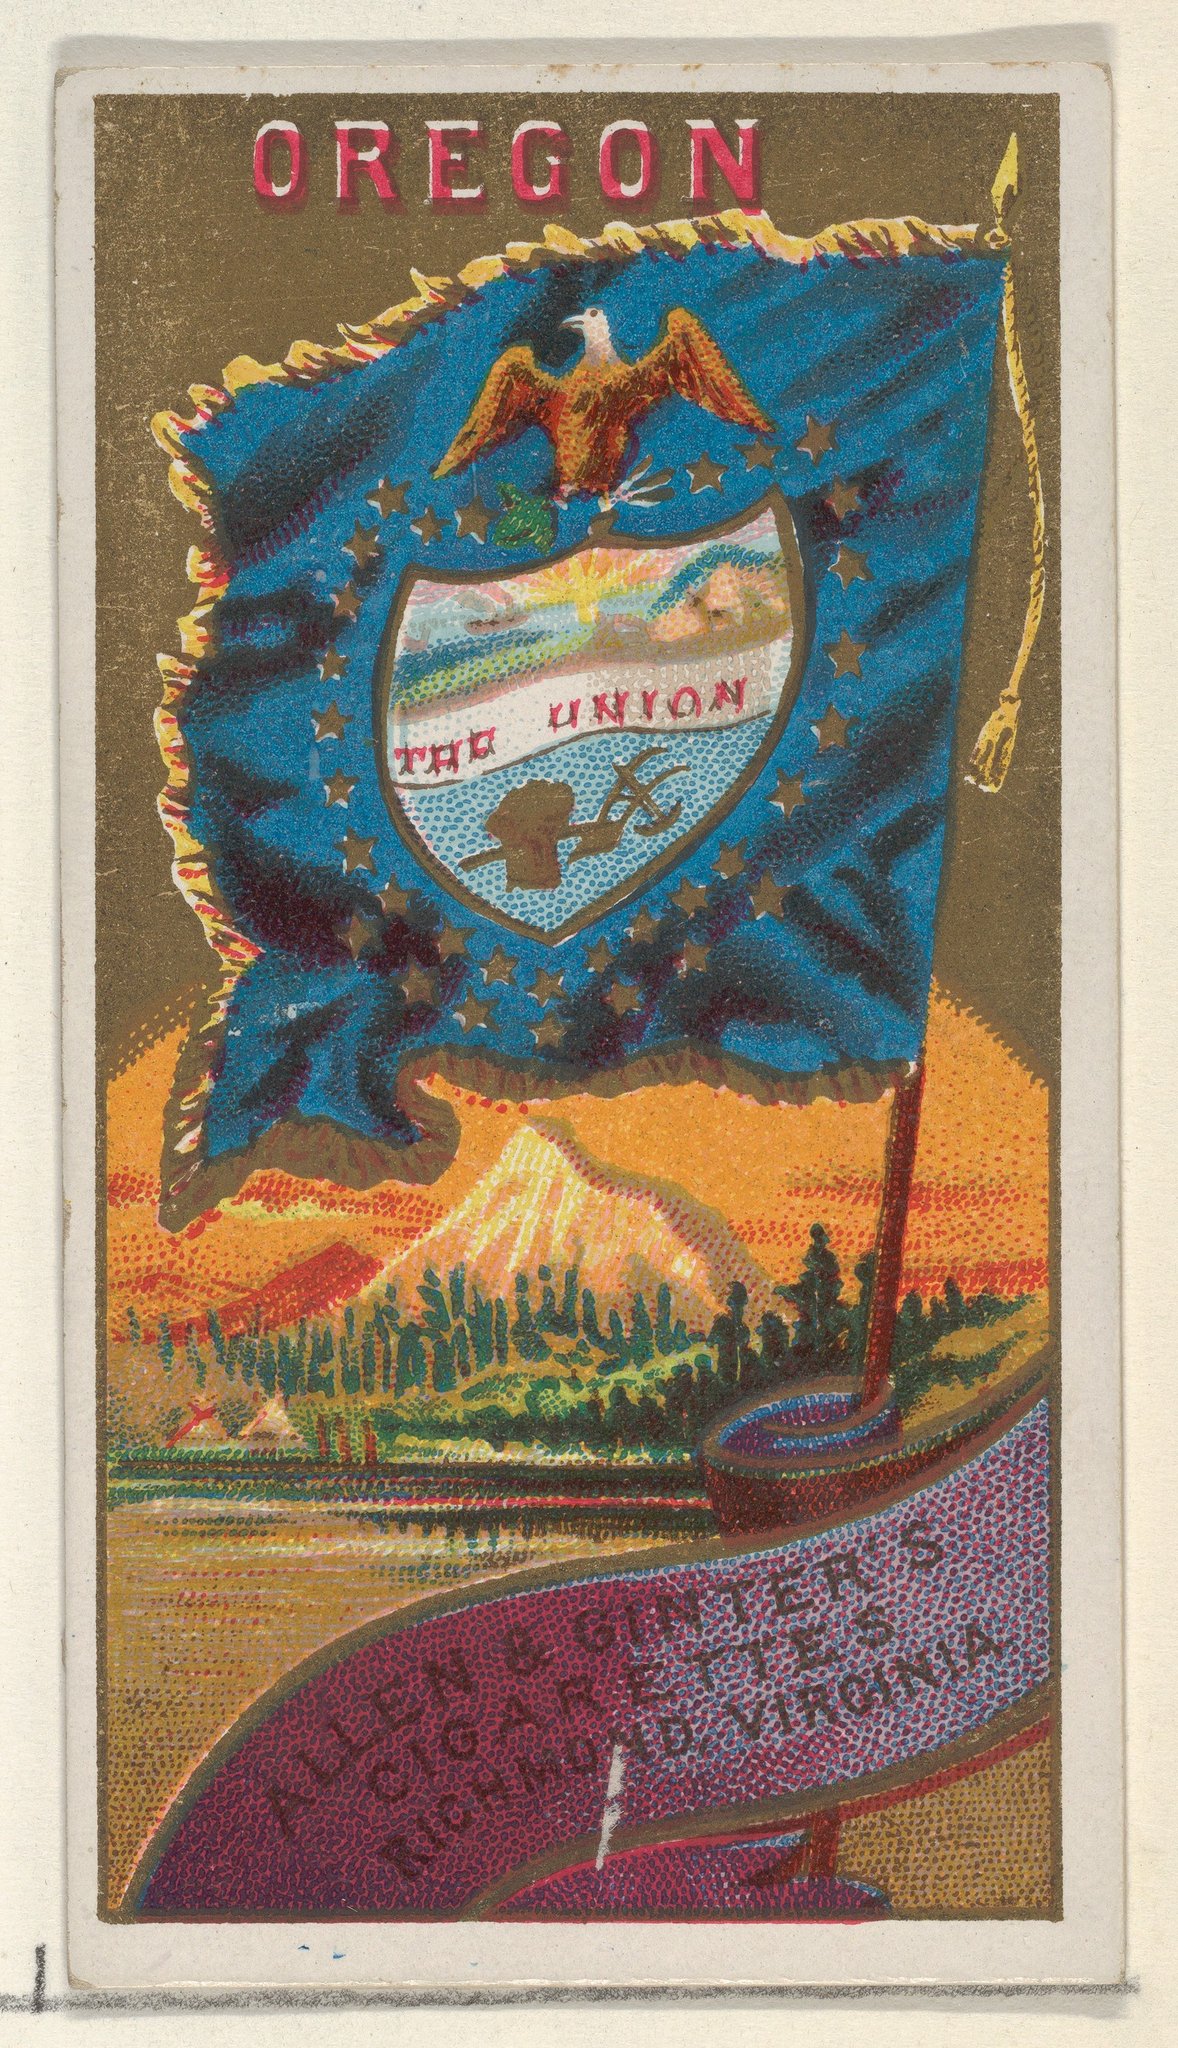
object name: print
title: Oregon, from Flags of the States and Territories (N11) for Allen & Ginter Cigarettes Brands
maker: allen & ginter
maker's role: publisher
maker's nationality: american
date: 1888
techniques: color lithograph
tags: flags